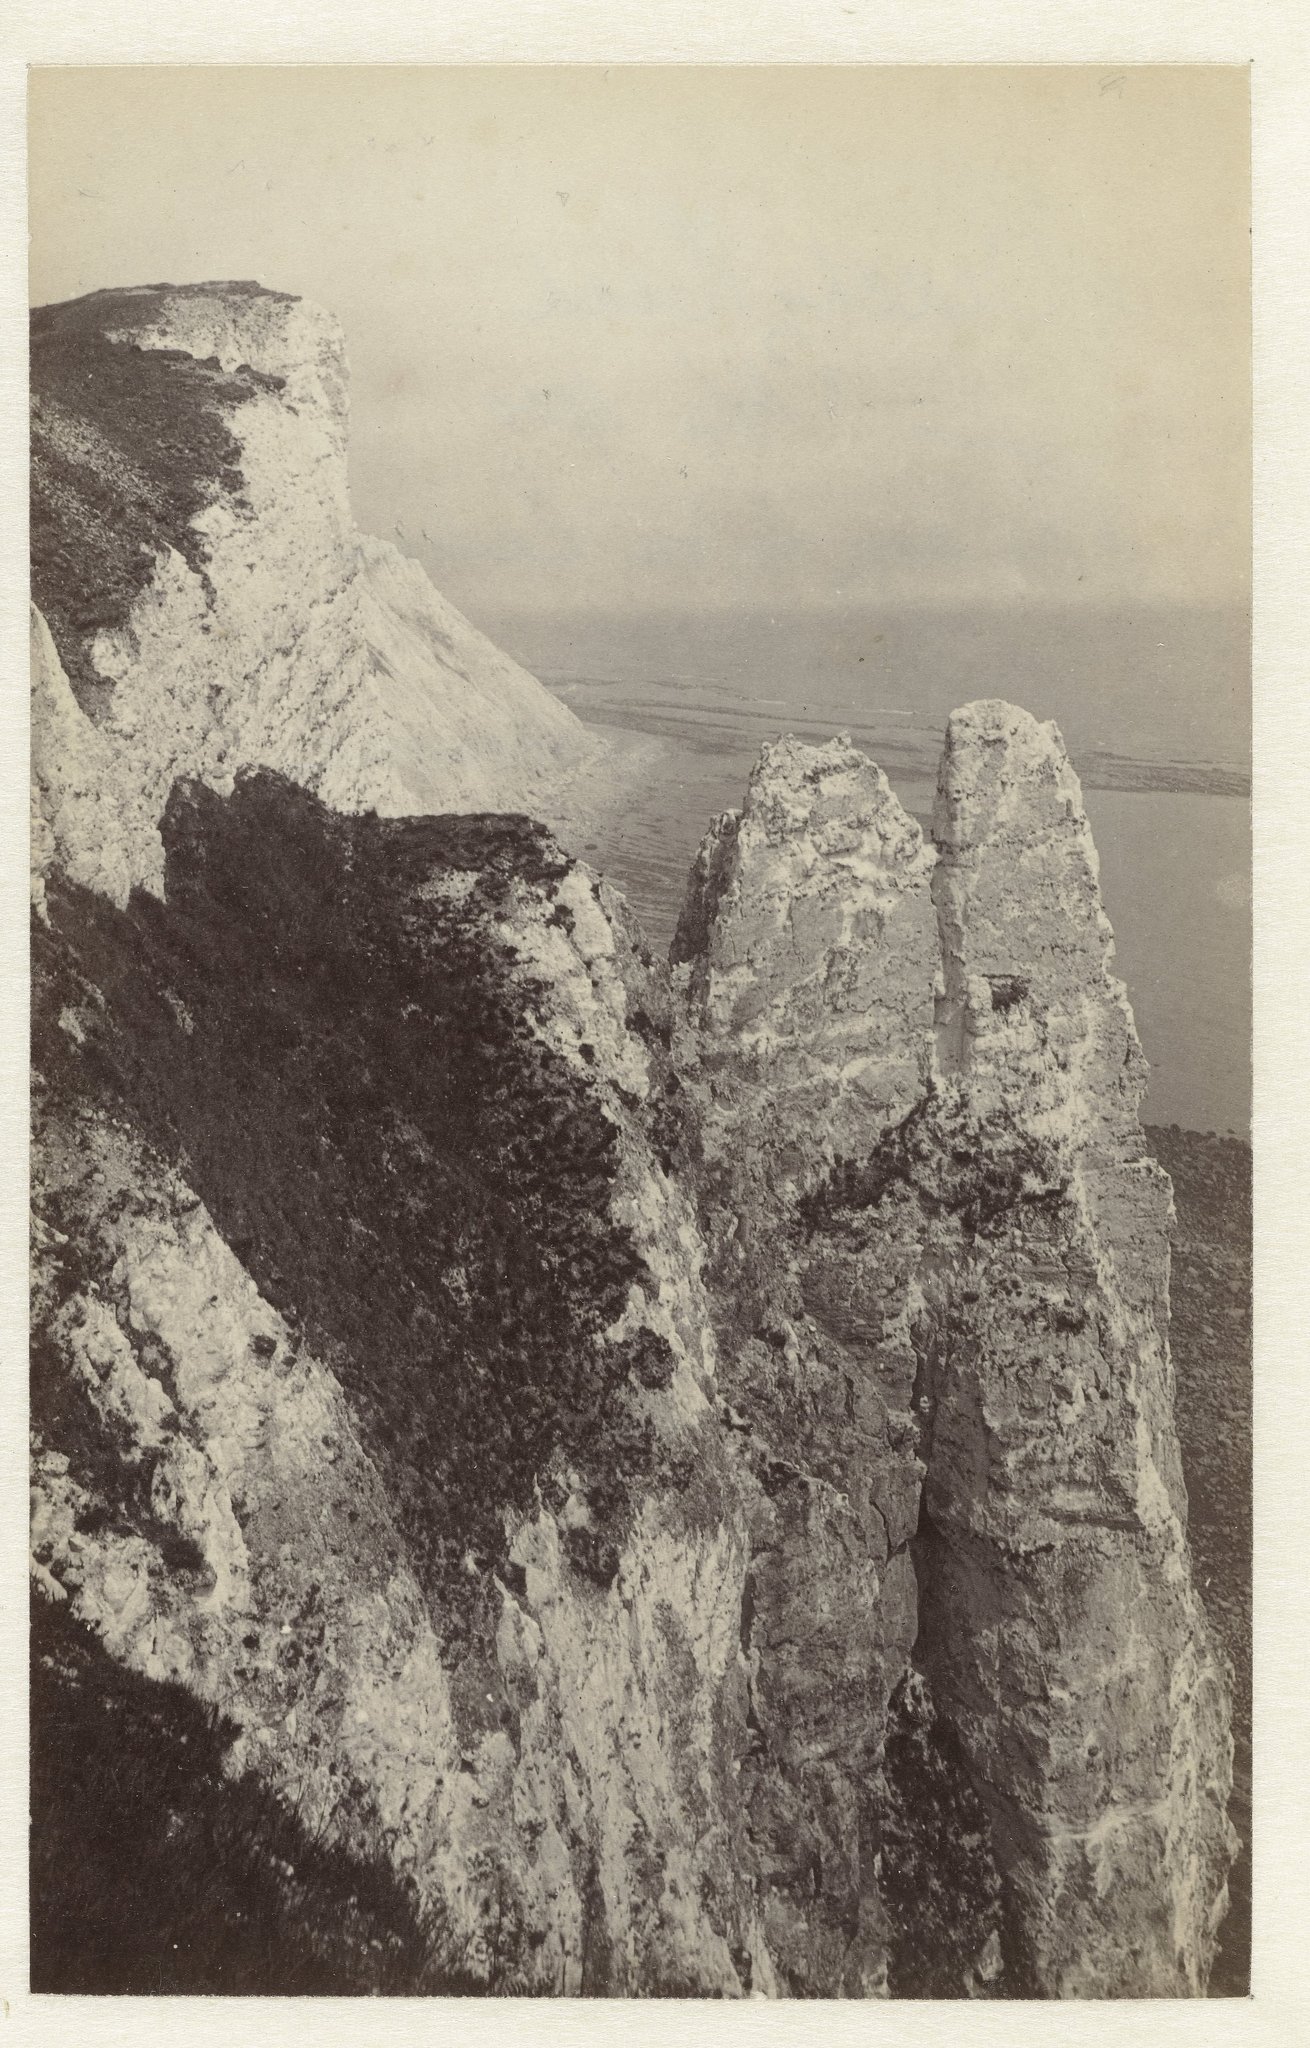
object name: photograph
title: Gezicht op Beachy Head nabij Eastbourne, East Sussex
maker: Anonymous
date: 1900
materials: paper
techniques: albumen print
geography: east sussex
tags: coastal cliff or crag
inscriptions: inscription: ‘25325/ Beachy Head’, inscription: ‘Beachy Head/ 14/4 1900/ The day before Eastern/ near Eastbourne’